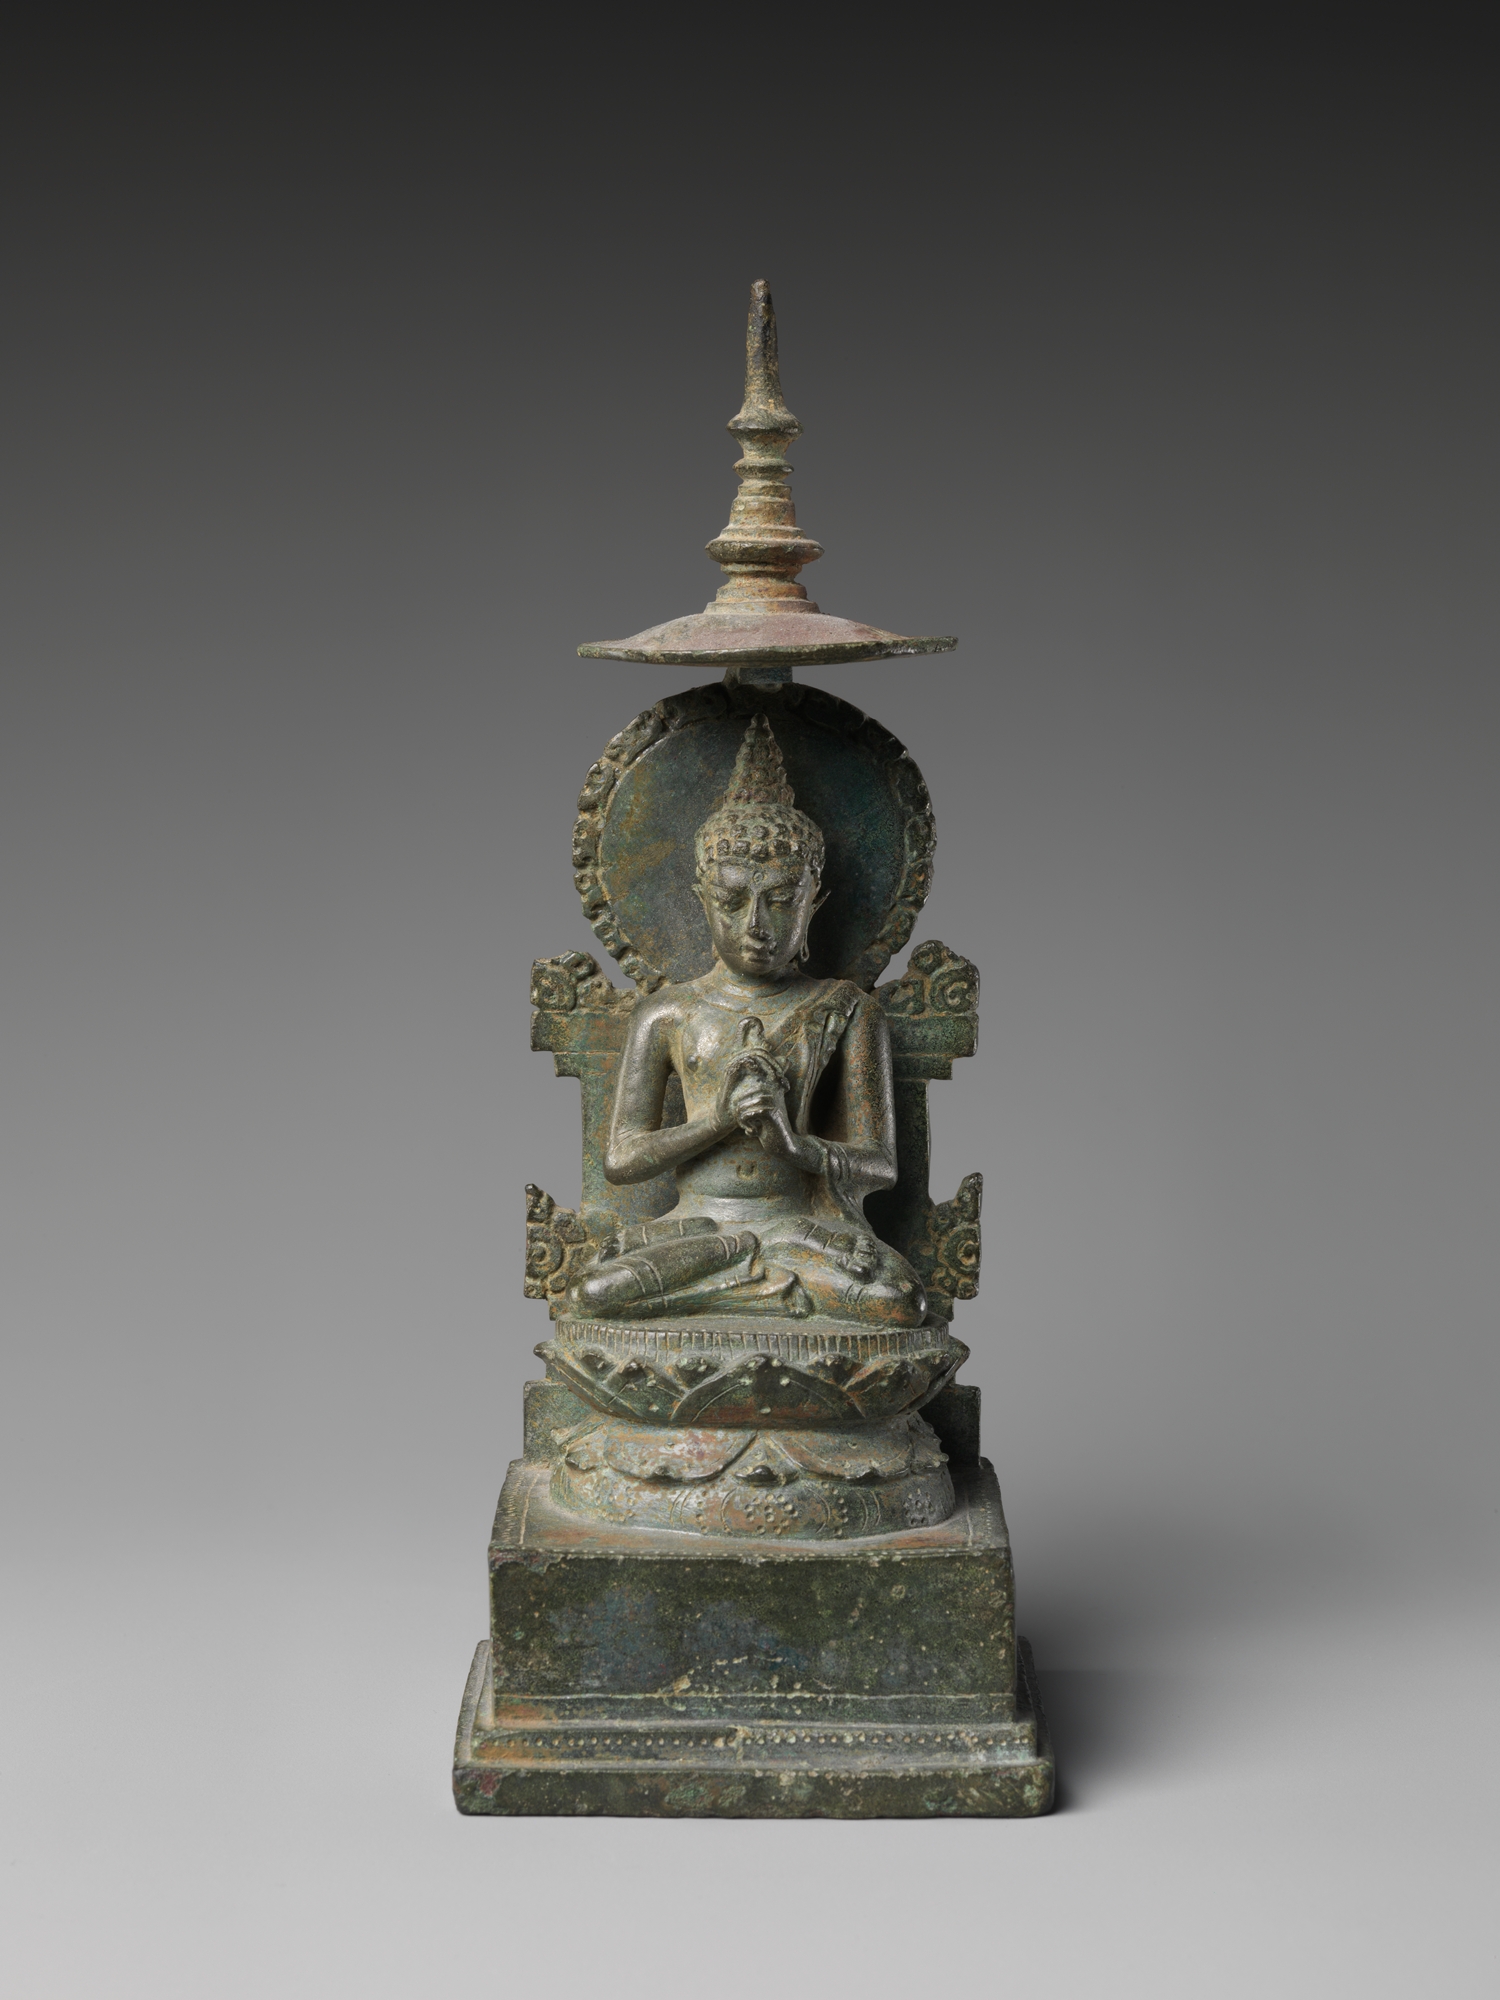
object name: figure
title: Seated Vairochana, the Transcendent Buddha of the Center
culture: indonesian, javanese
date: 901-950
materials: bronze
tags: buddhism,buddha